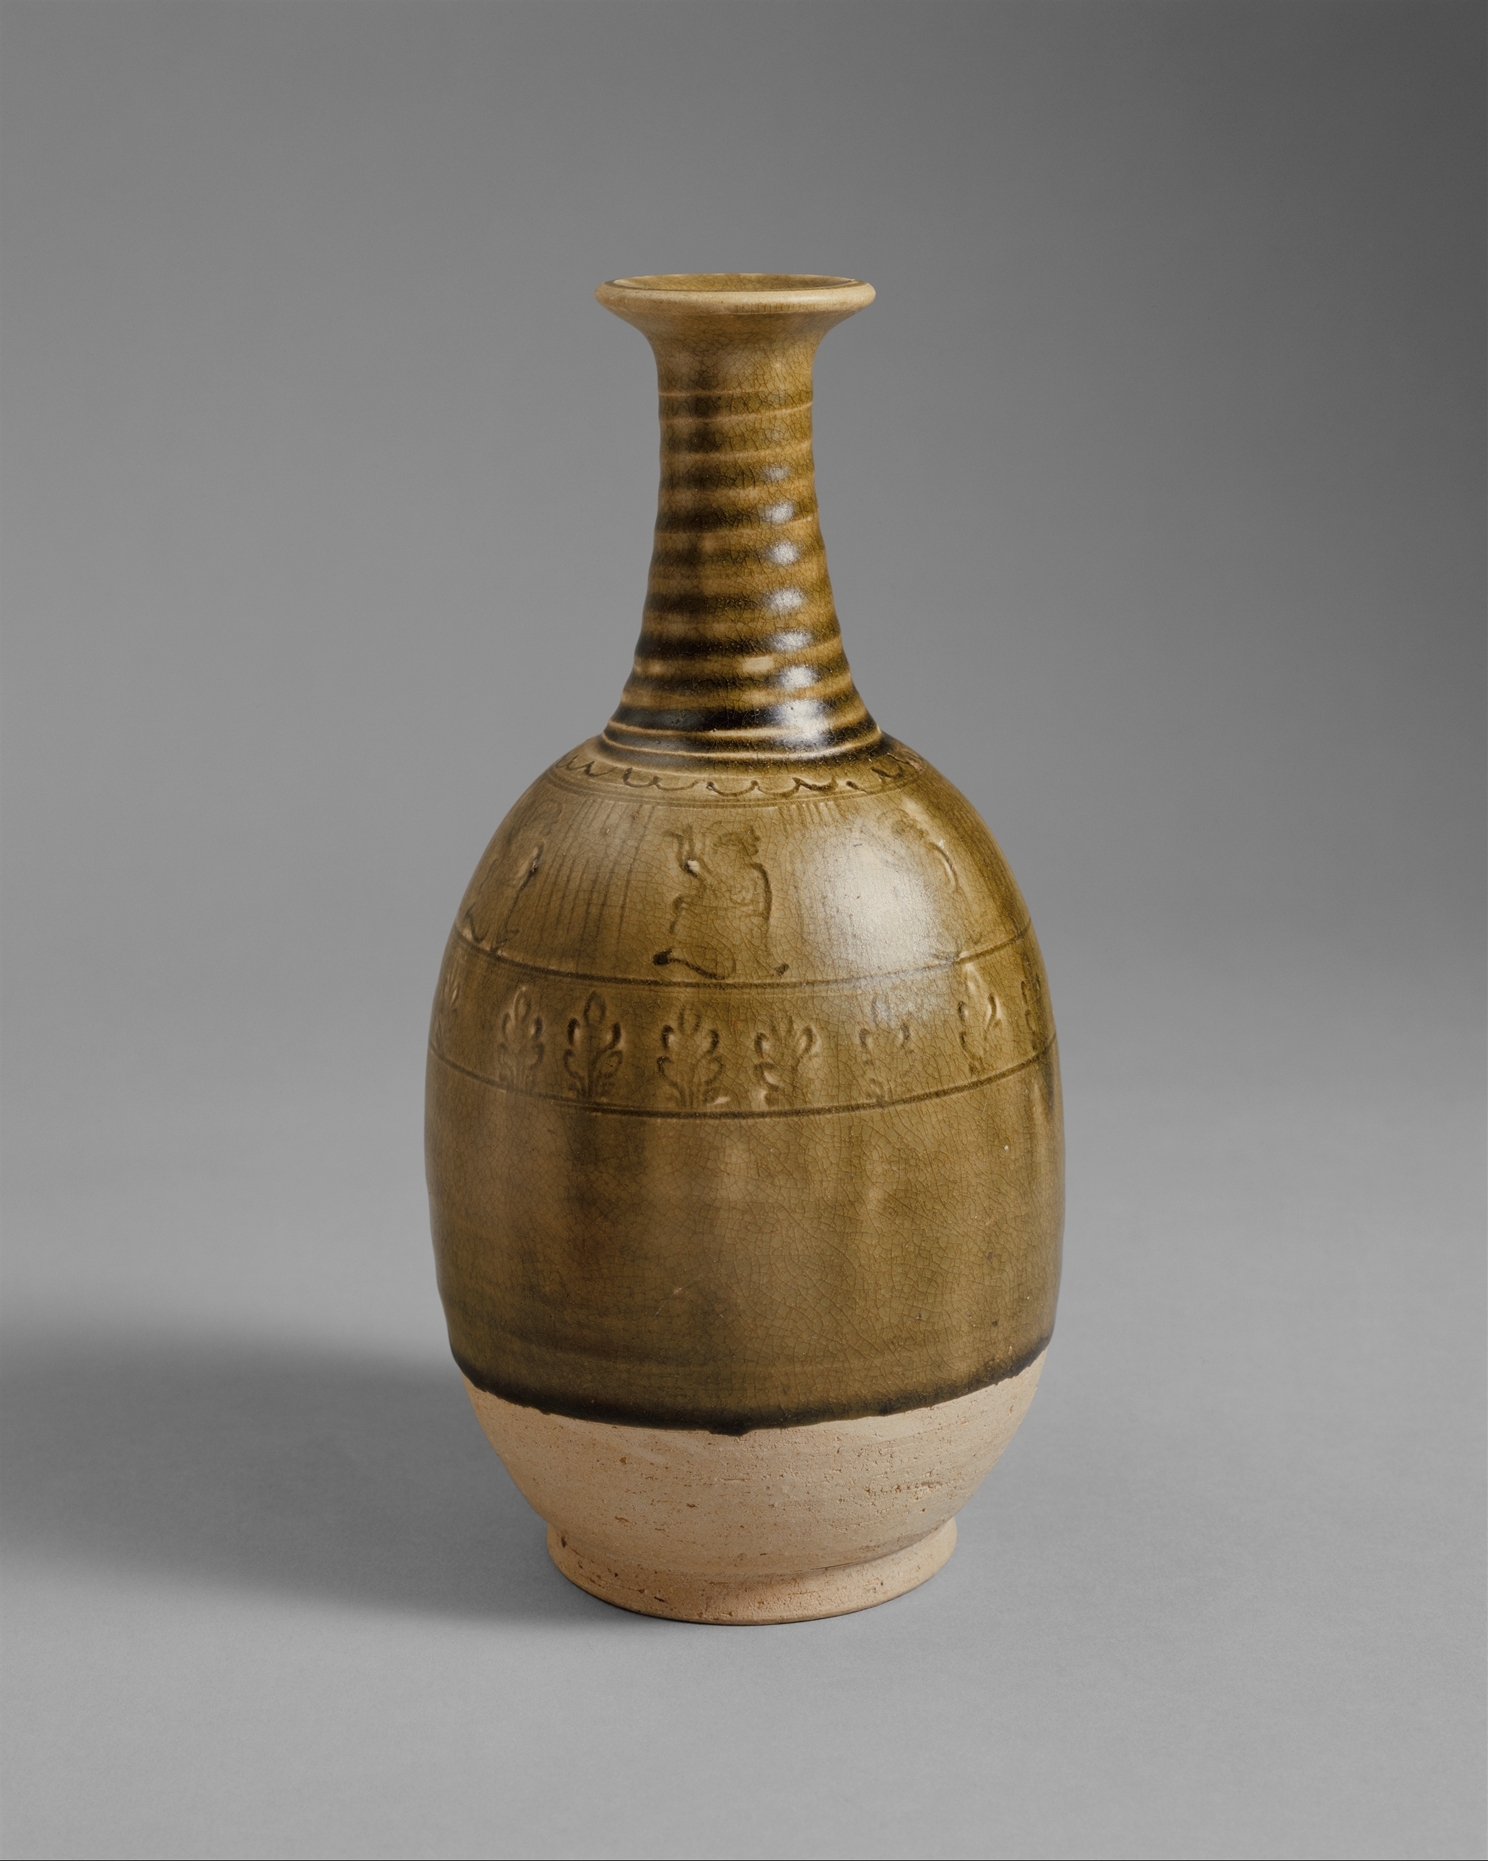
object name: bottle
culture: chinese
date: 501-700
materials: stoneware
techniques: glazing, incising